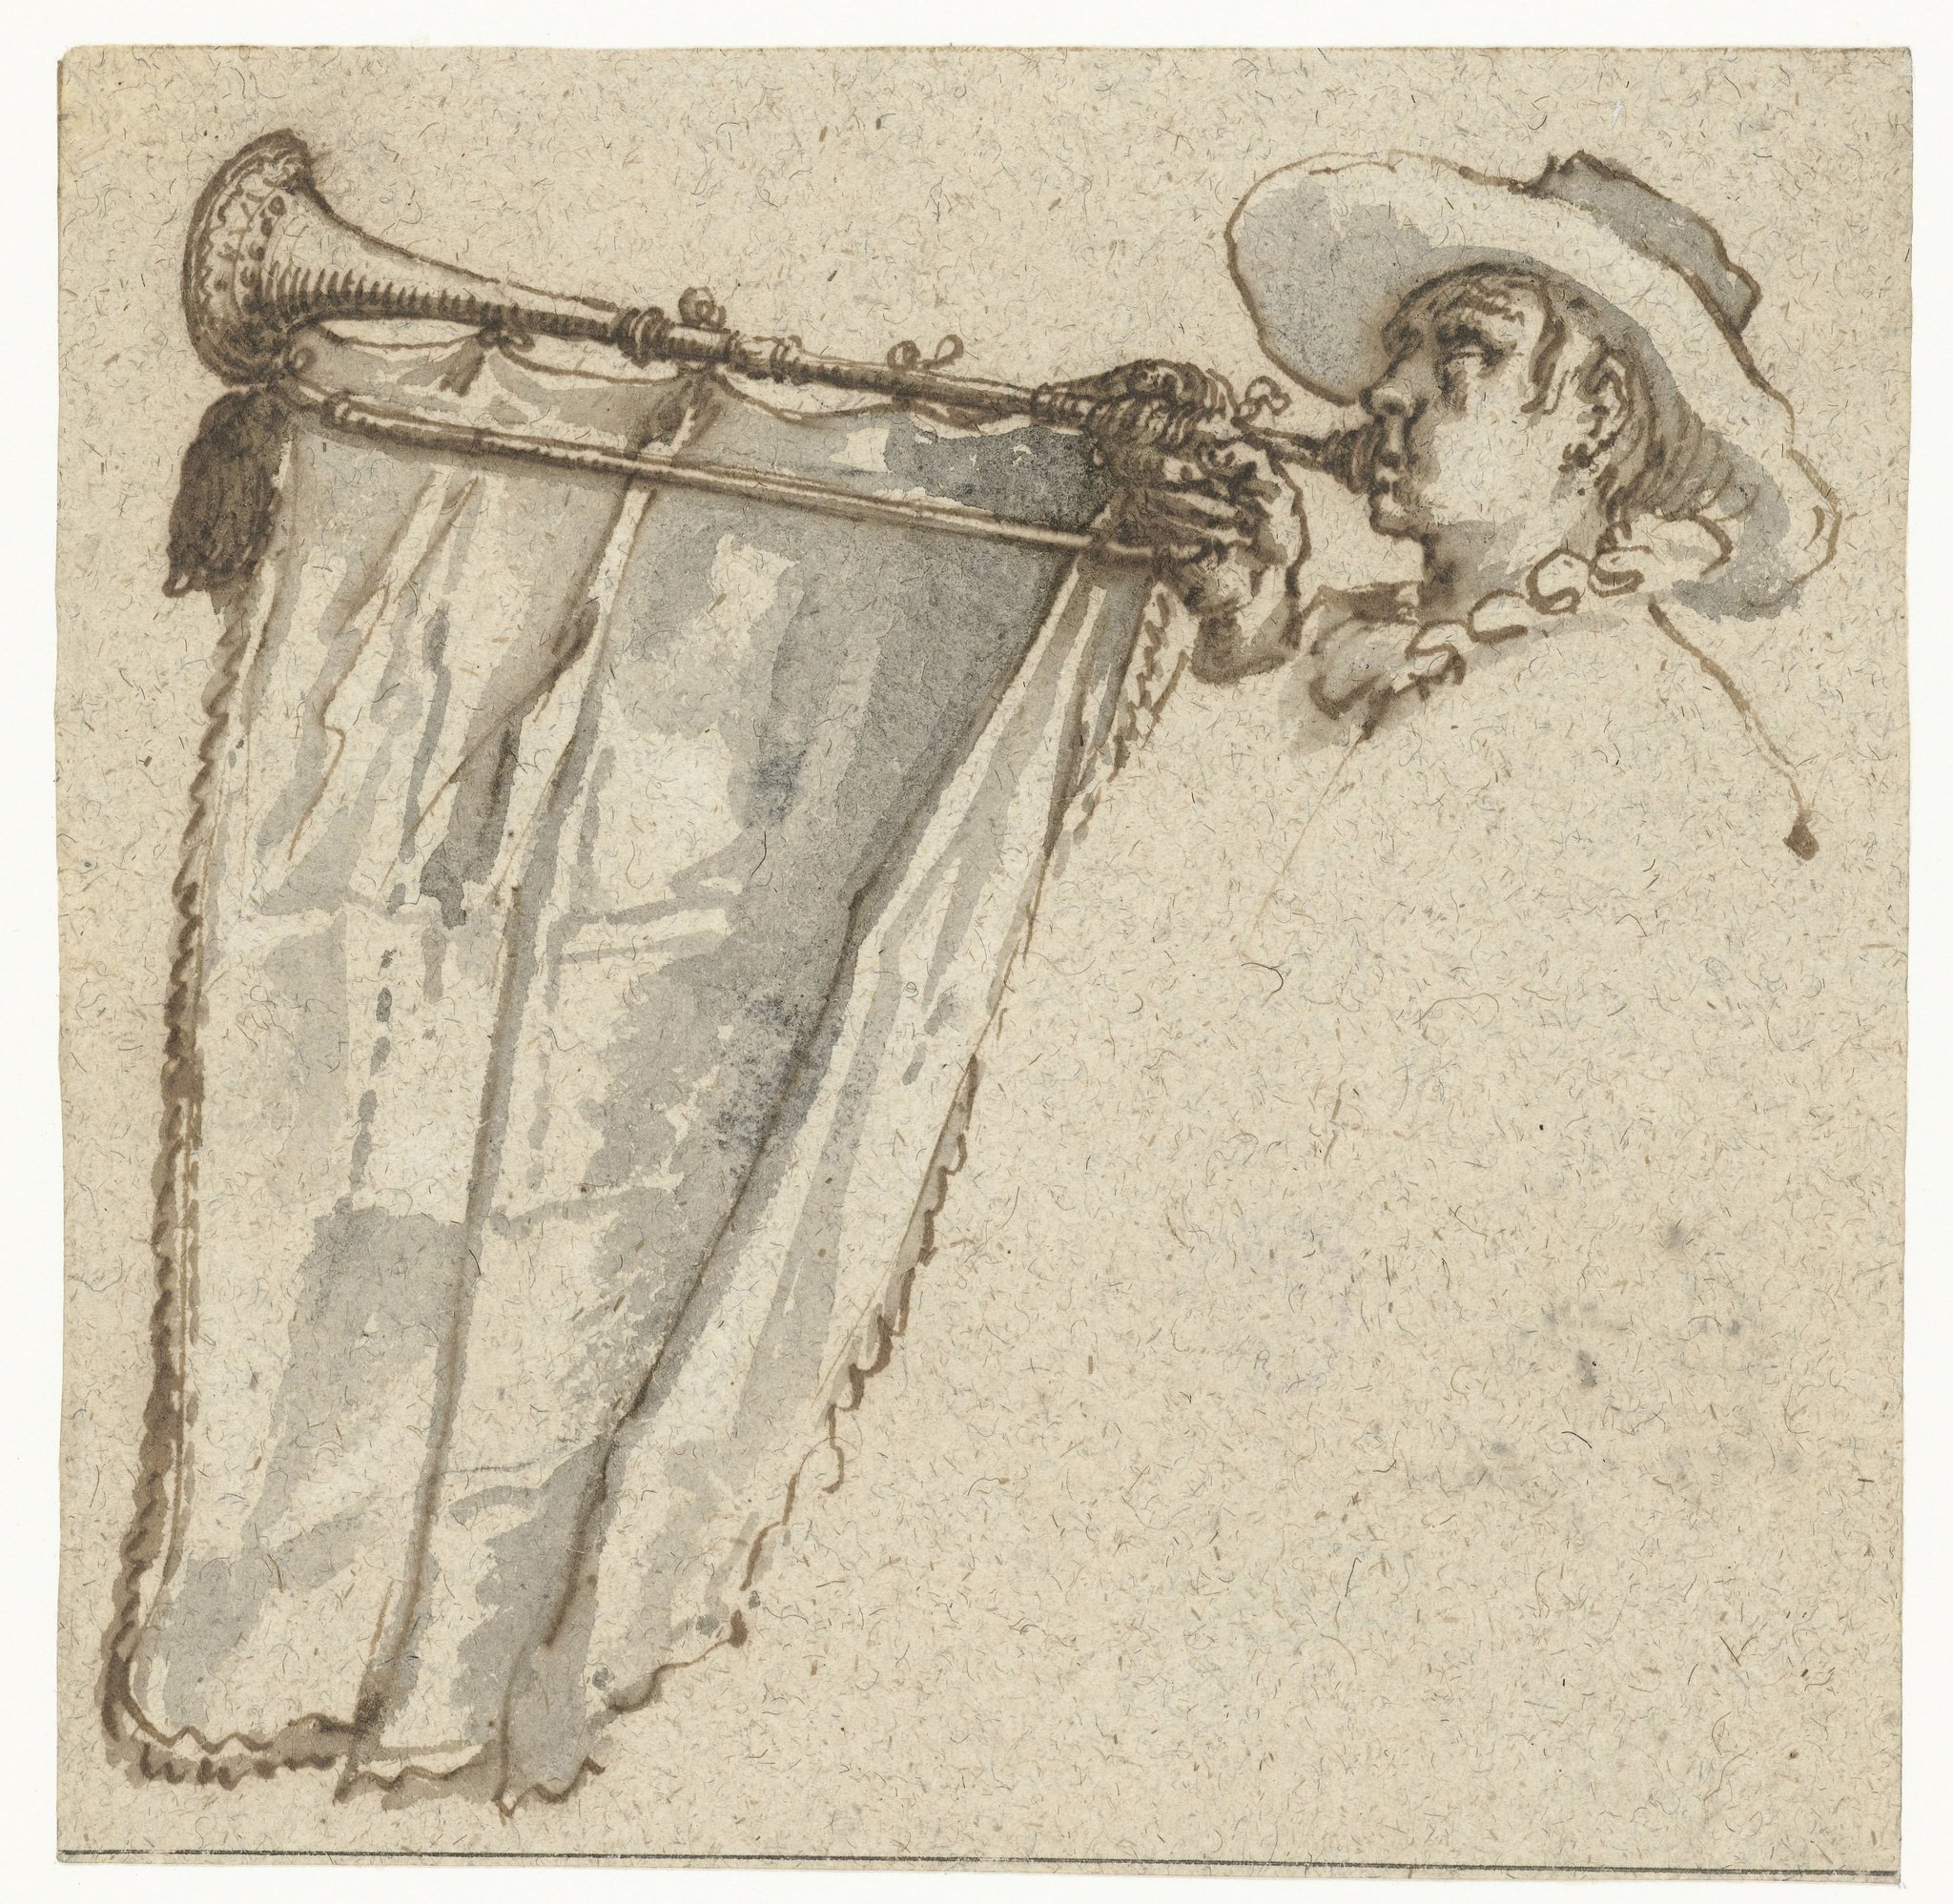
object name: drawing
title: Trumpeter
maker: jacques de gheyn (ii)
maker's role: painter, print maker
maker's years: 1565-1629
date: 1575-1629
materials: paper, ink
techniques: brush, pen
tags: horn, trumpet, cornet, trombone, tuba, military music